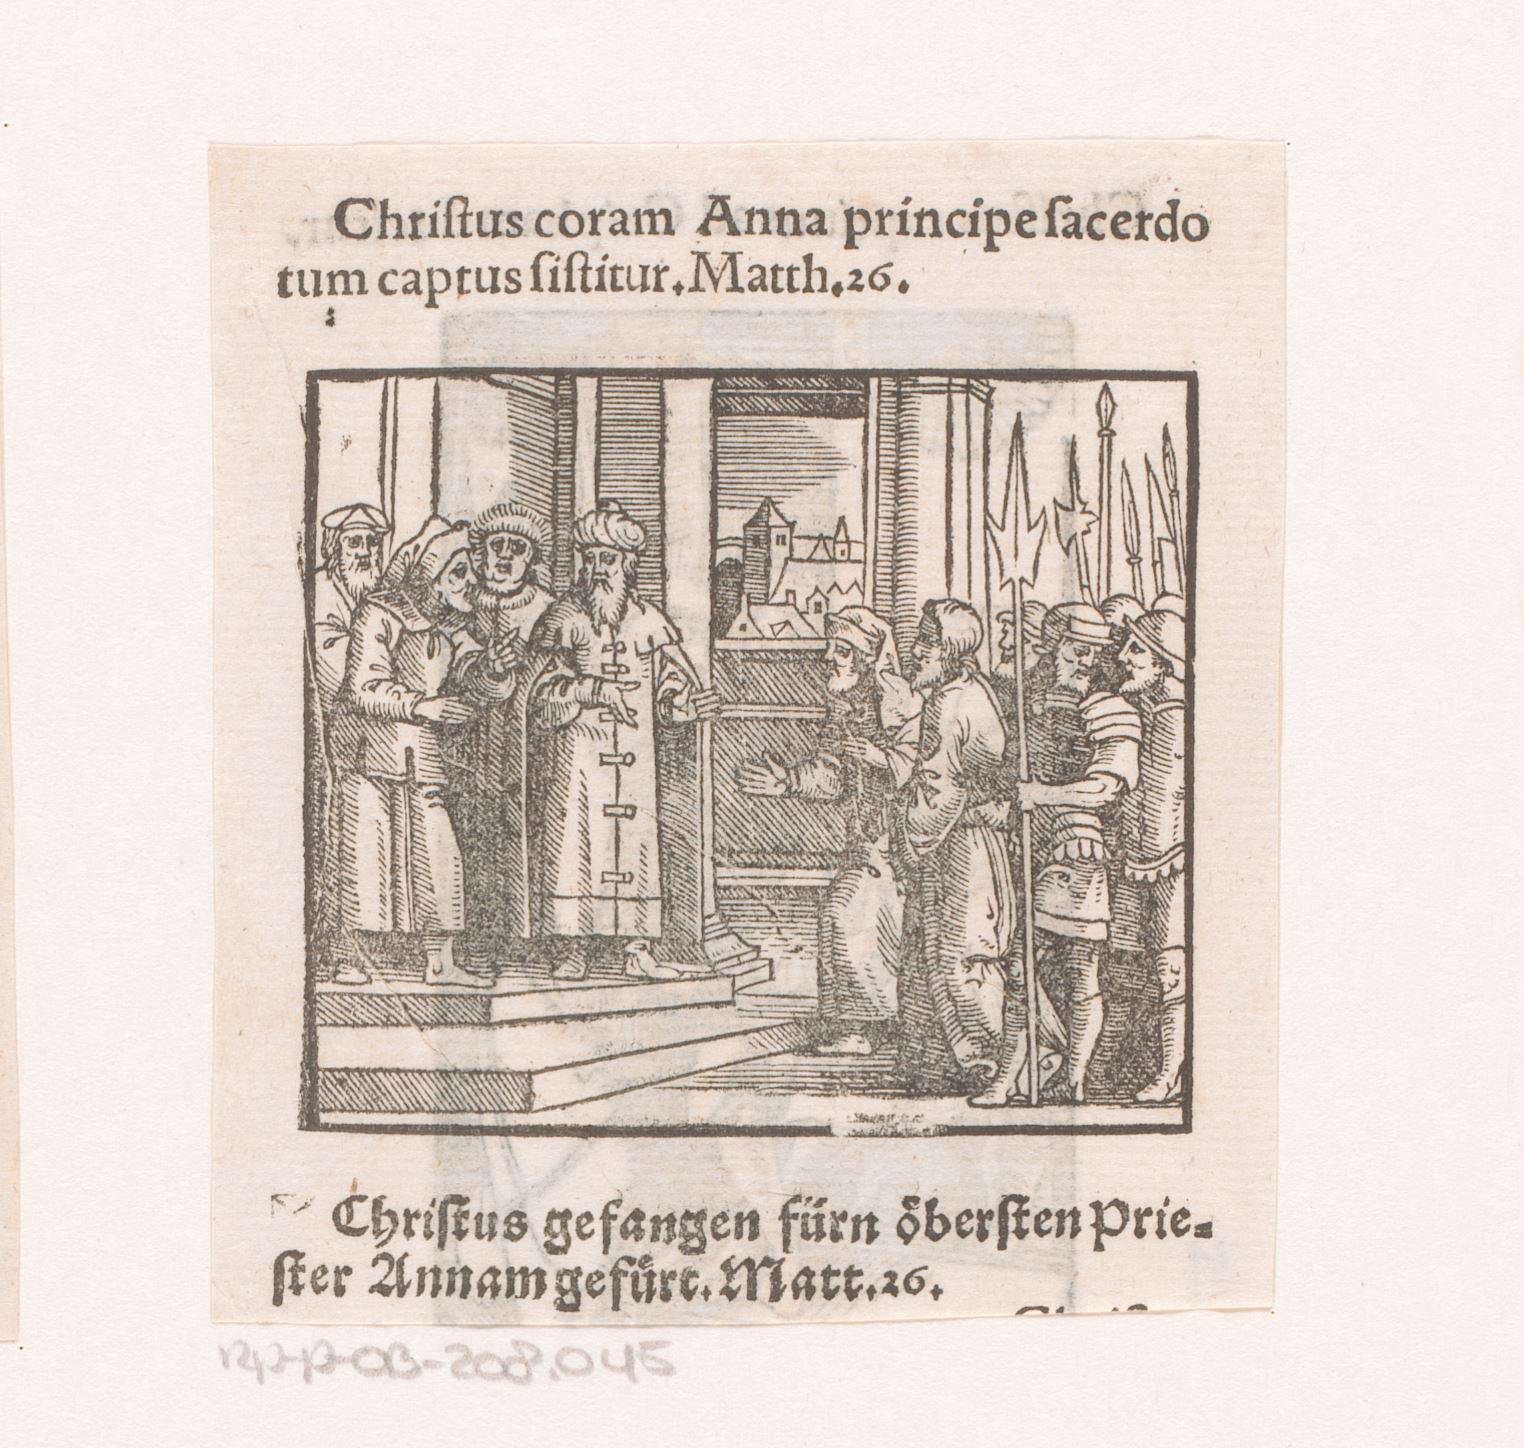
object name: print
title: Christus voor Annas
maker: Anonymous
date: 1600-1699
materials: paper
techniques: letterpress printing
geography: netherlands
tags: christ before annas (hanna); maybe a soldier about to strike christ (john 18:13, 18:19-24)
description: Christus wordt door gewapende soldaten voor de hogepriester Annas geleid.